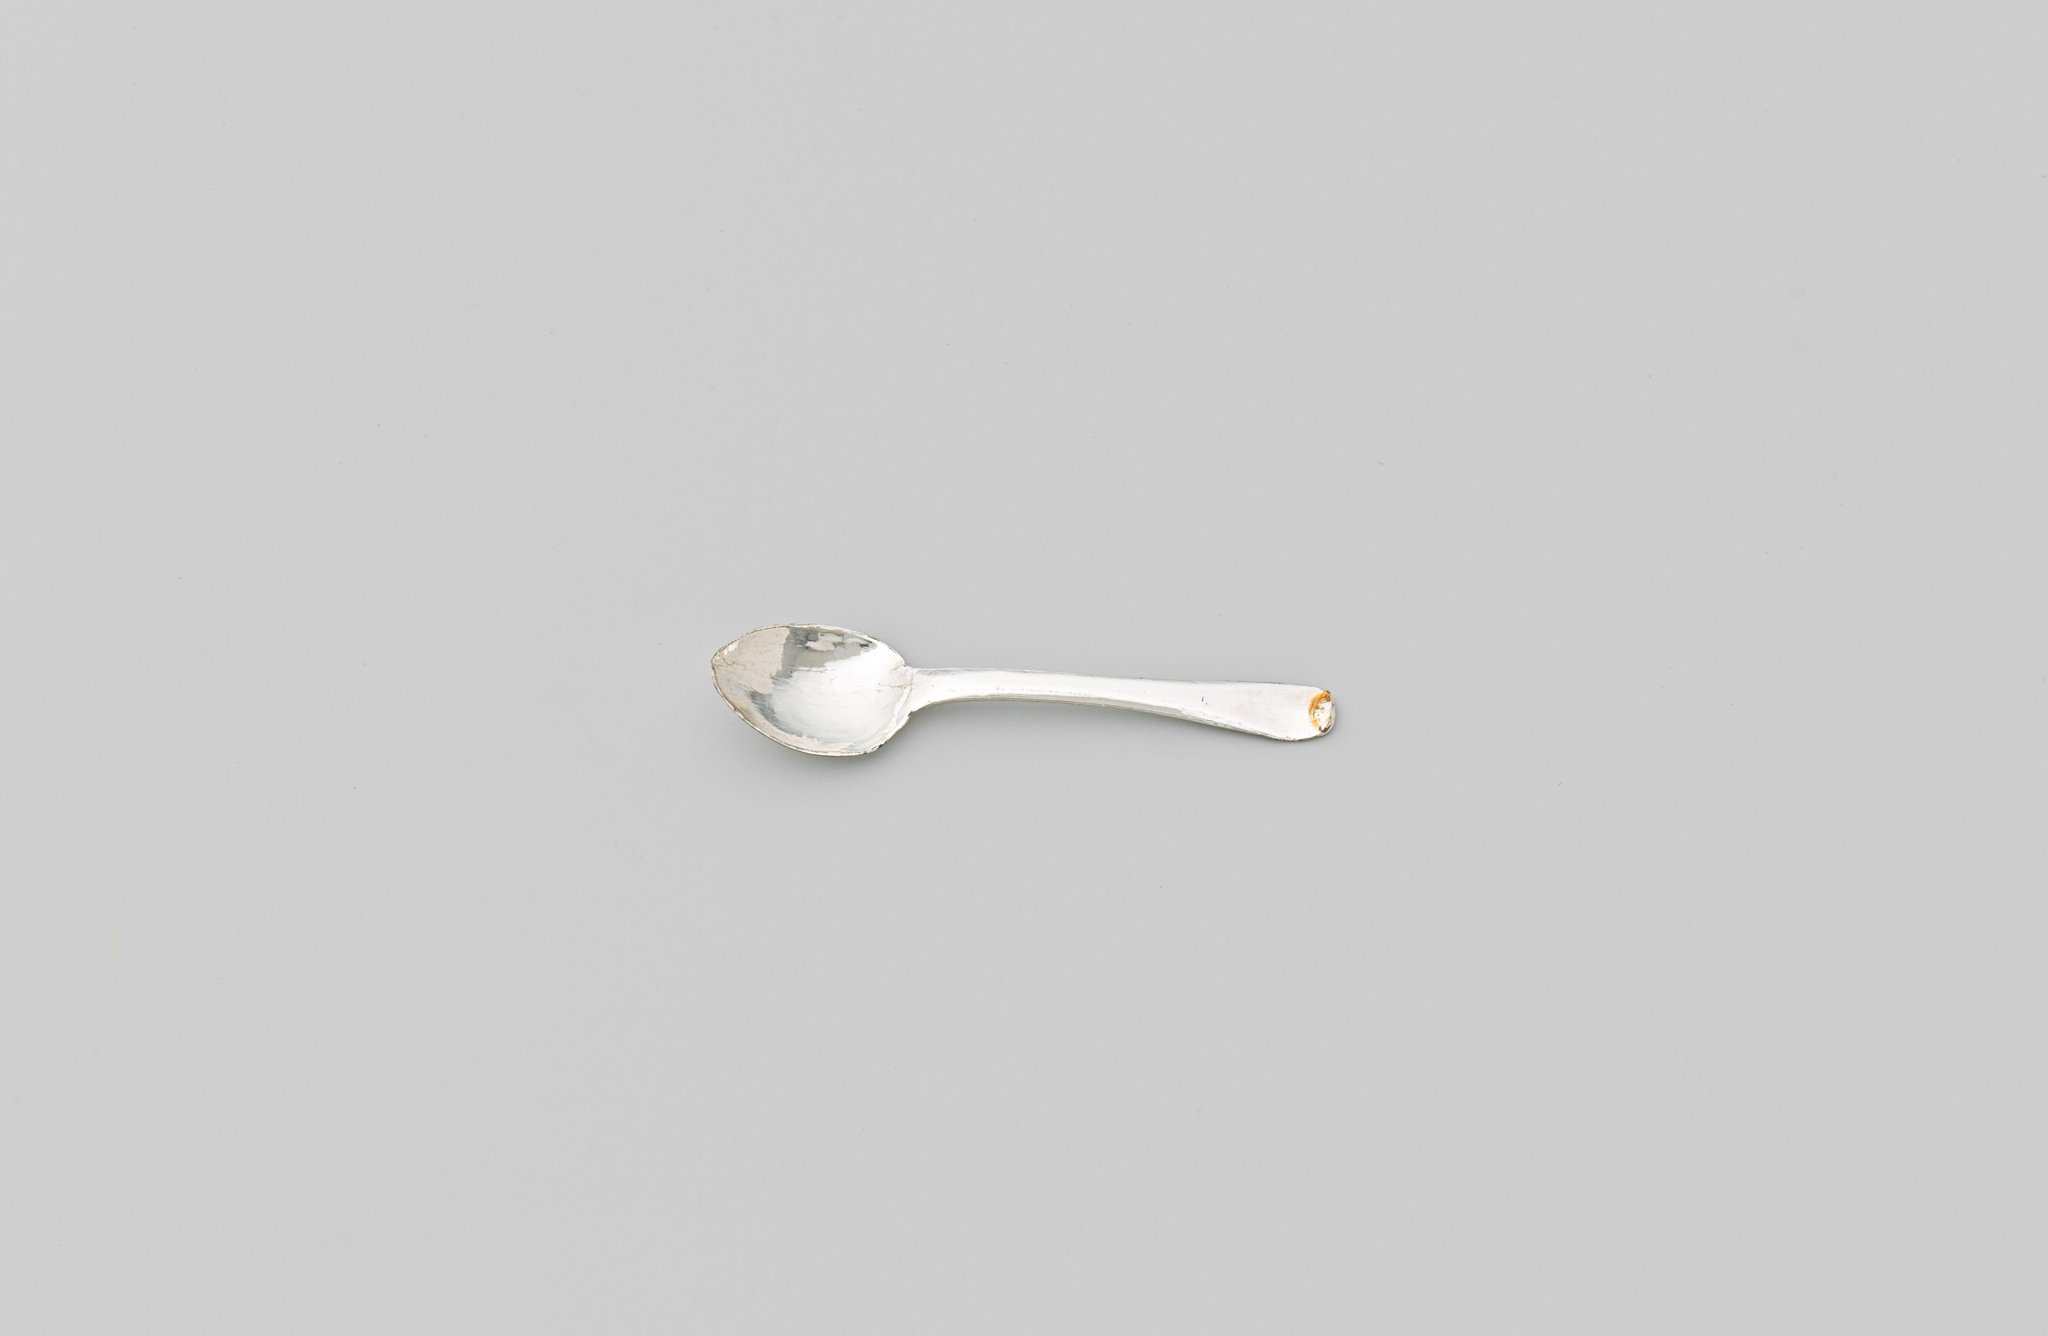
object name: miniature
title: Miniatuur lepel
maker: Anonymous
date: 1750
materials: silver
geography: amsterdam